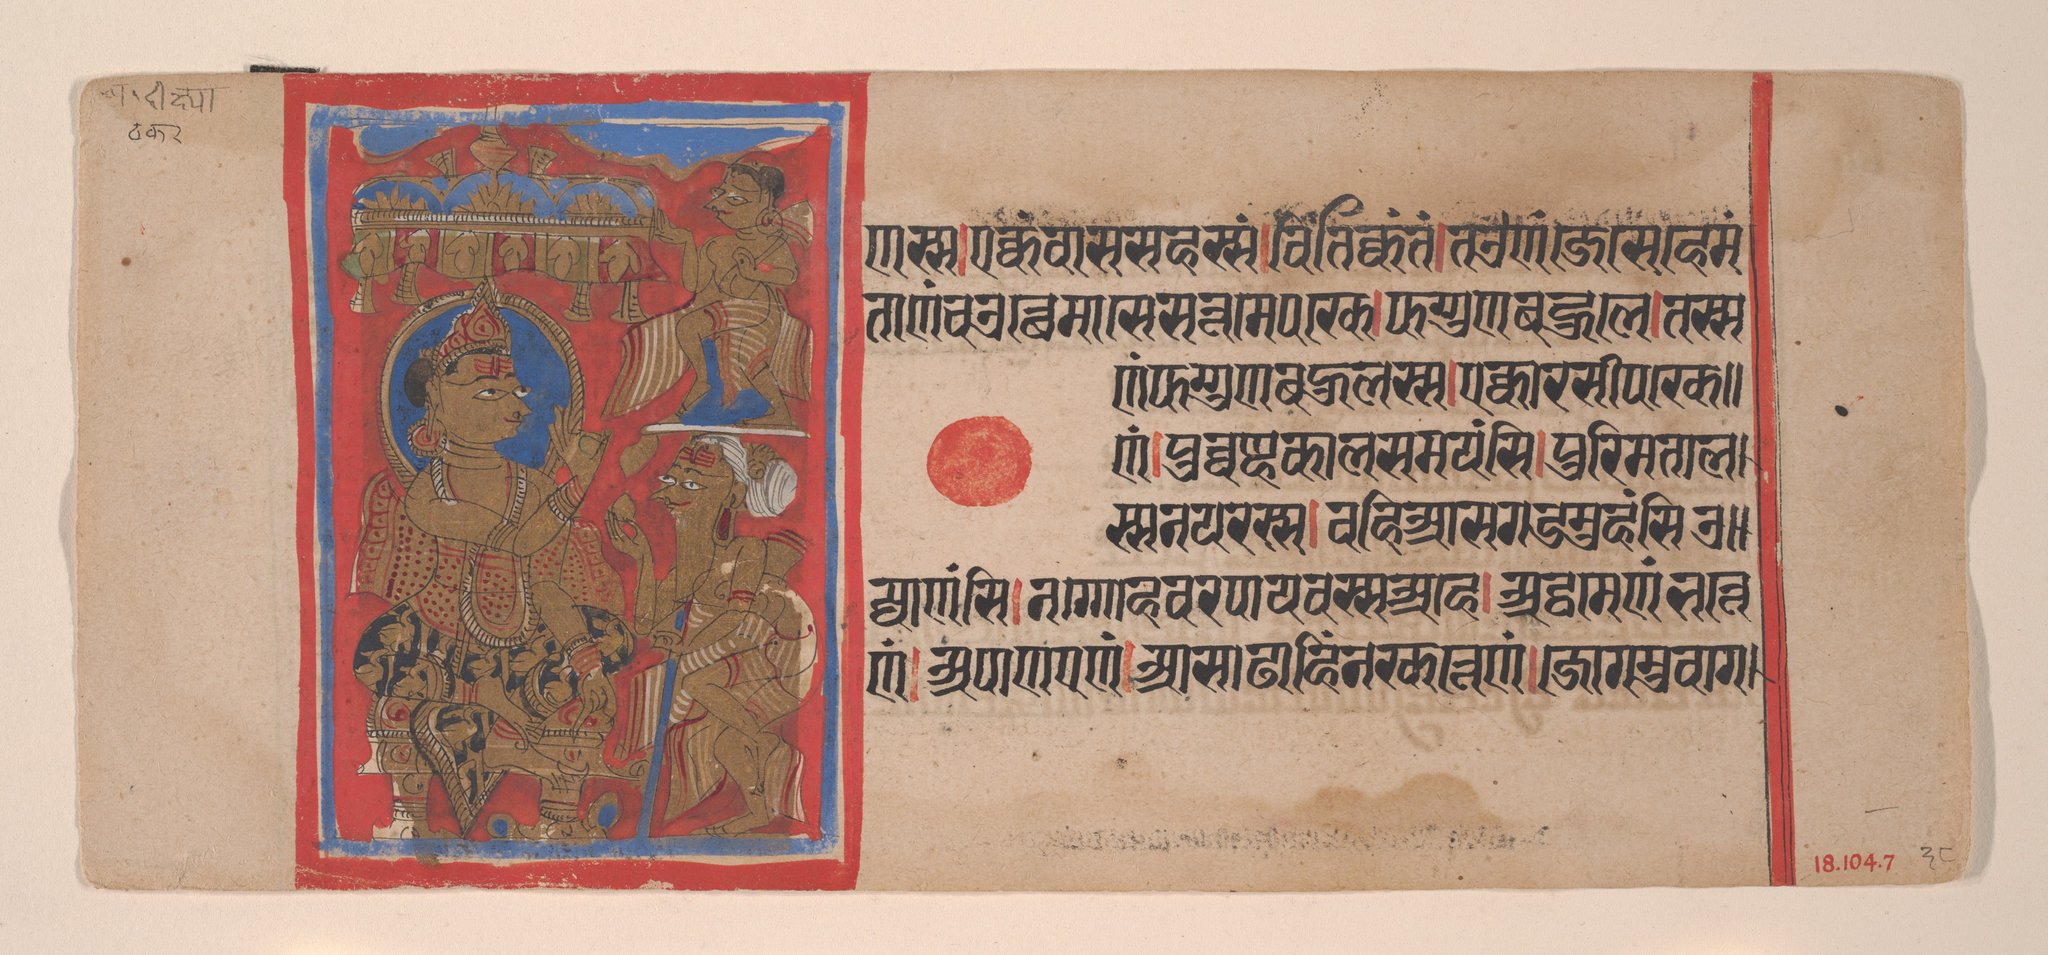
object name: manuscript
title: Mahavira Distributes Wealth: Folio from a Kalpasutra Manuscript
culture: indian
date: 1461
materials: gold, ink, paper, watercolor